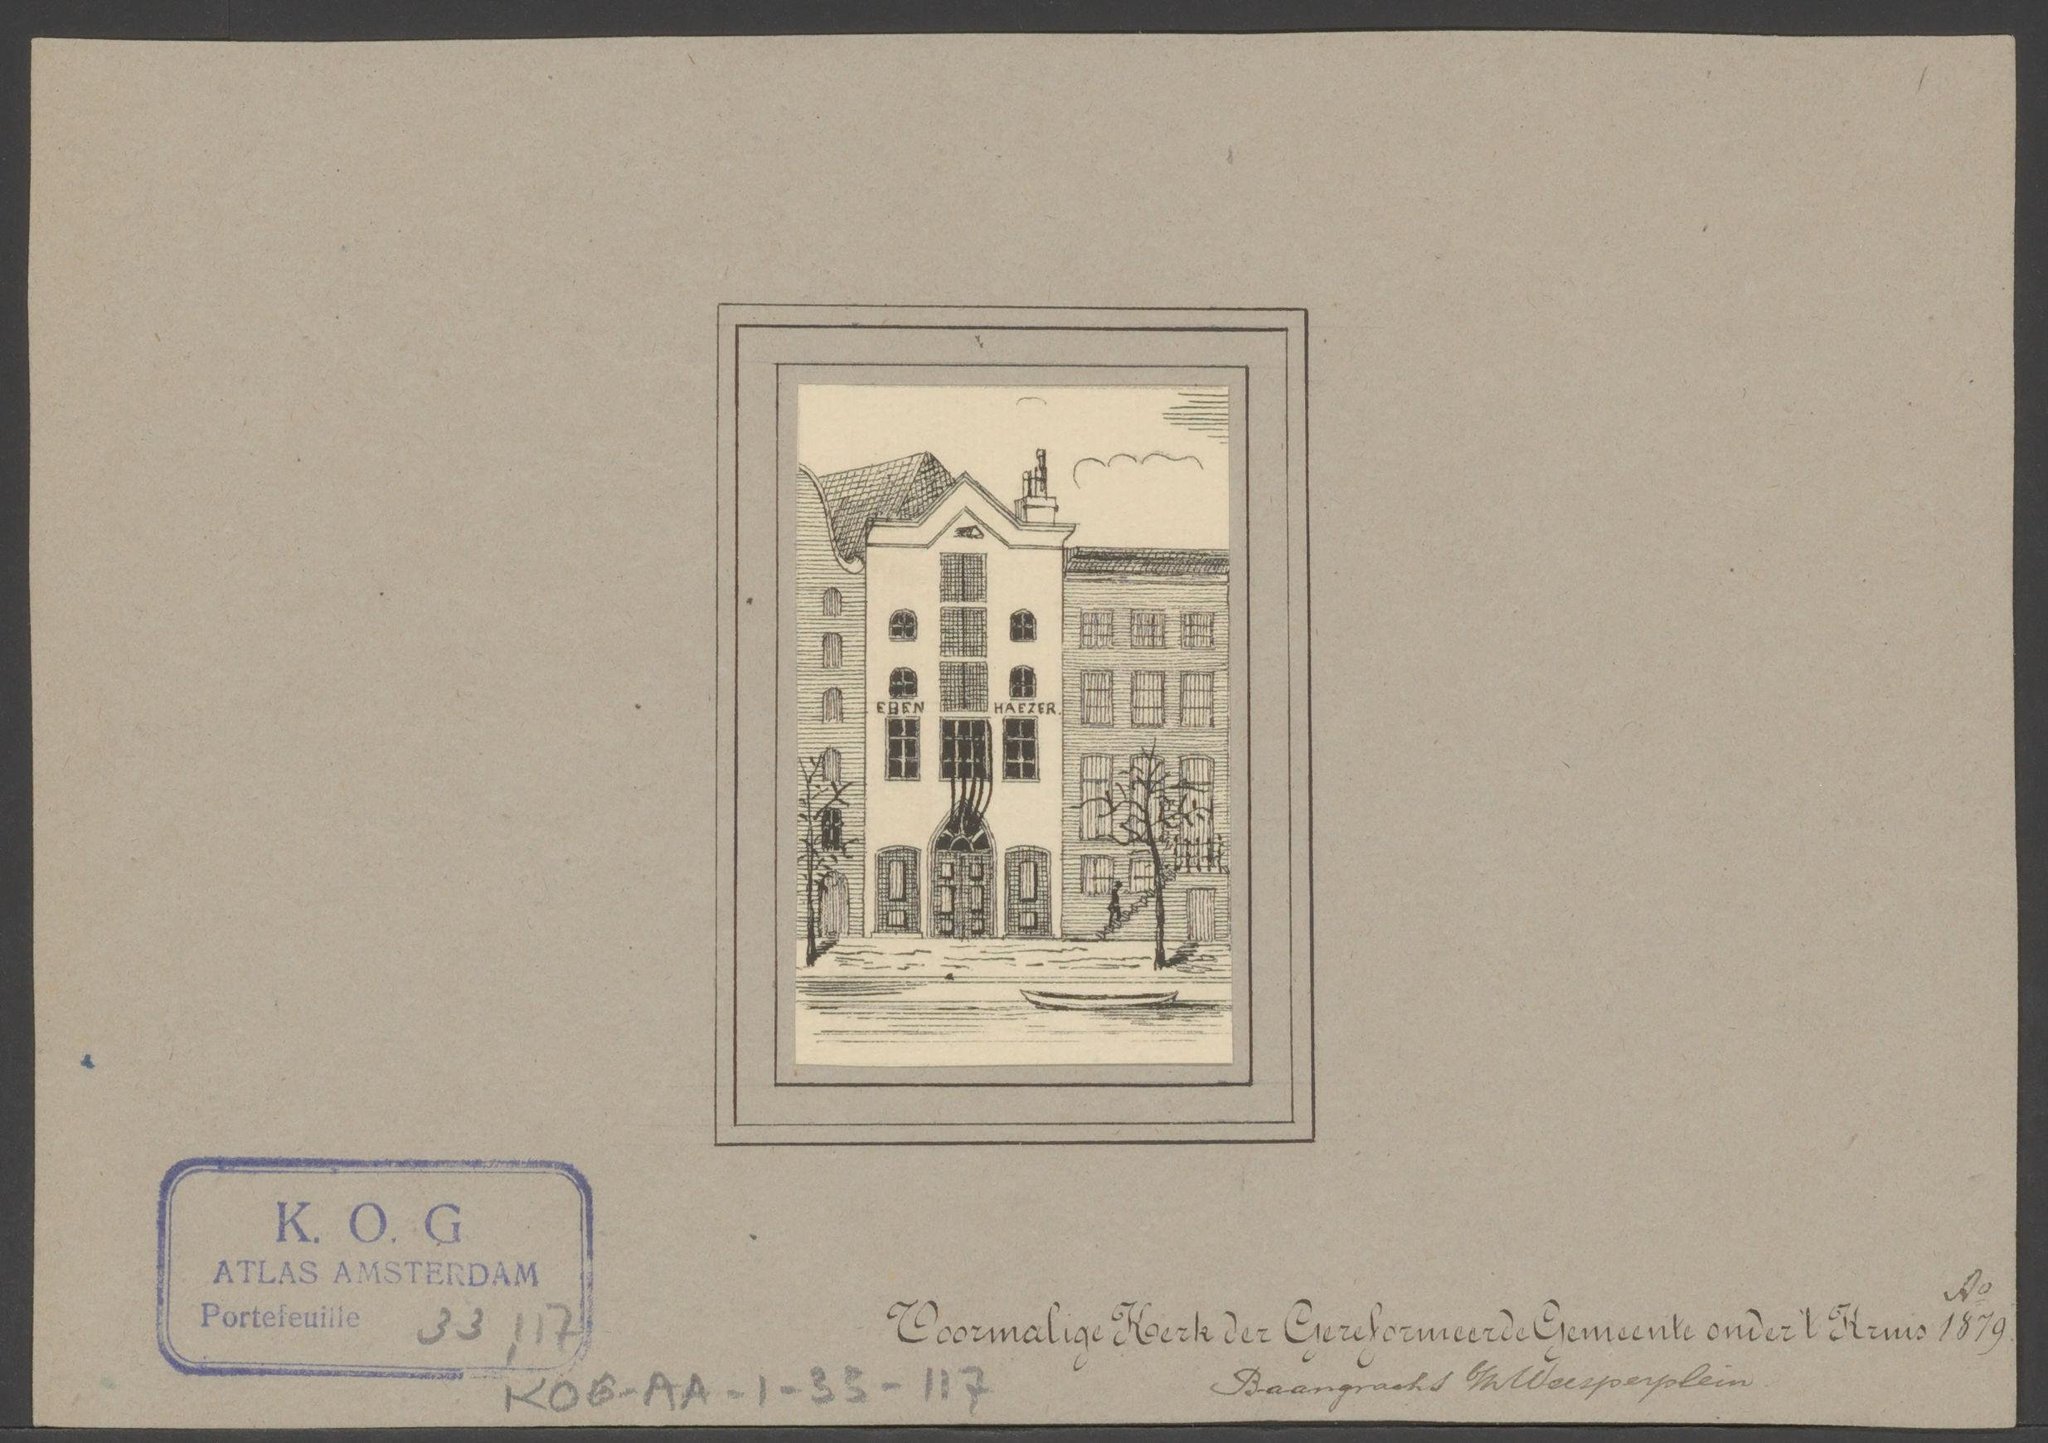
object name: drawing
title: Gezicht op de kerk van de Gereformeerde Gemeente onder het Kruis te Amsterdam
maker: Anonymous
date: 1879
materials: ink, paper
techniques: pen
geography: amsterdam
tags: church (exterior), canals, waters (in city)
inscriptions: collector's mark: Lugt 1641b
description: Onderwerpsrubriek binnen de Atlas Amsterdam: Kerkwezen: Gebouwen diverse gemeenten: Gereformeerde Gemeente onder het Kruis.